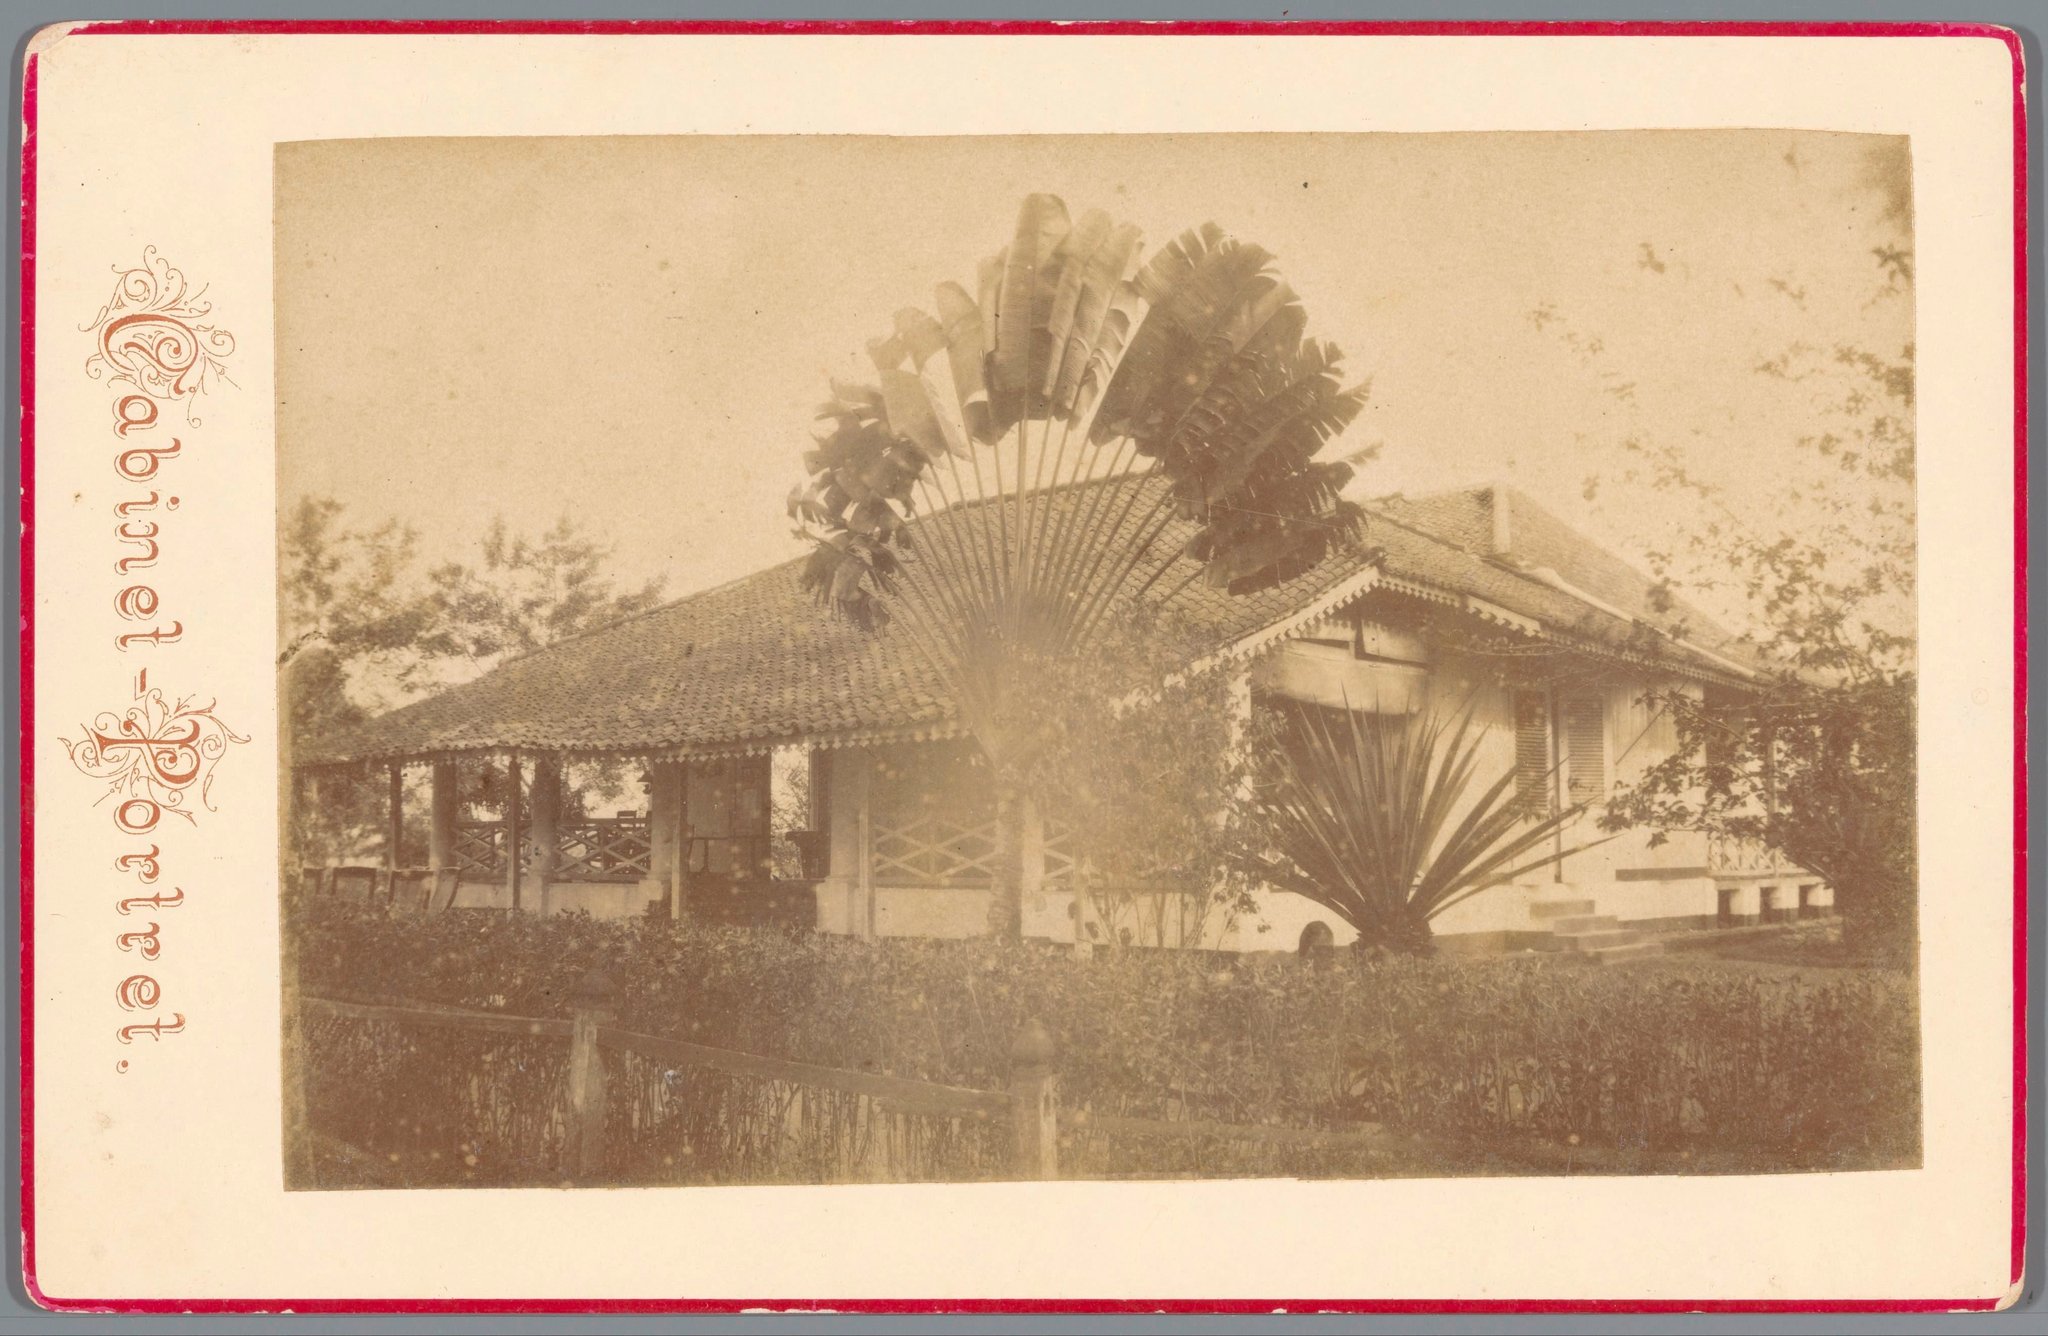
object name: cabinet photograph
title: Gebouw van sociëteit Schoonverbond, Palembang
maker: Anonymous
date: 1890-1910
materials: cardboard, paper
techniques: albumen print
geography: palembang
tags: villa, palembang (city)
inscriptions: inscription: ‘Cabinet-Portret’